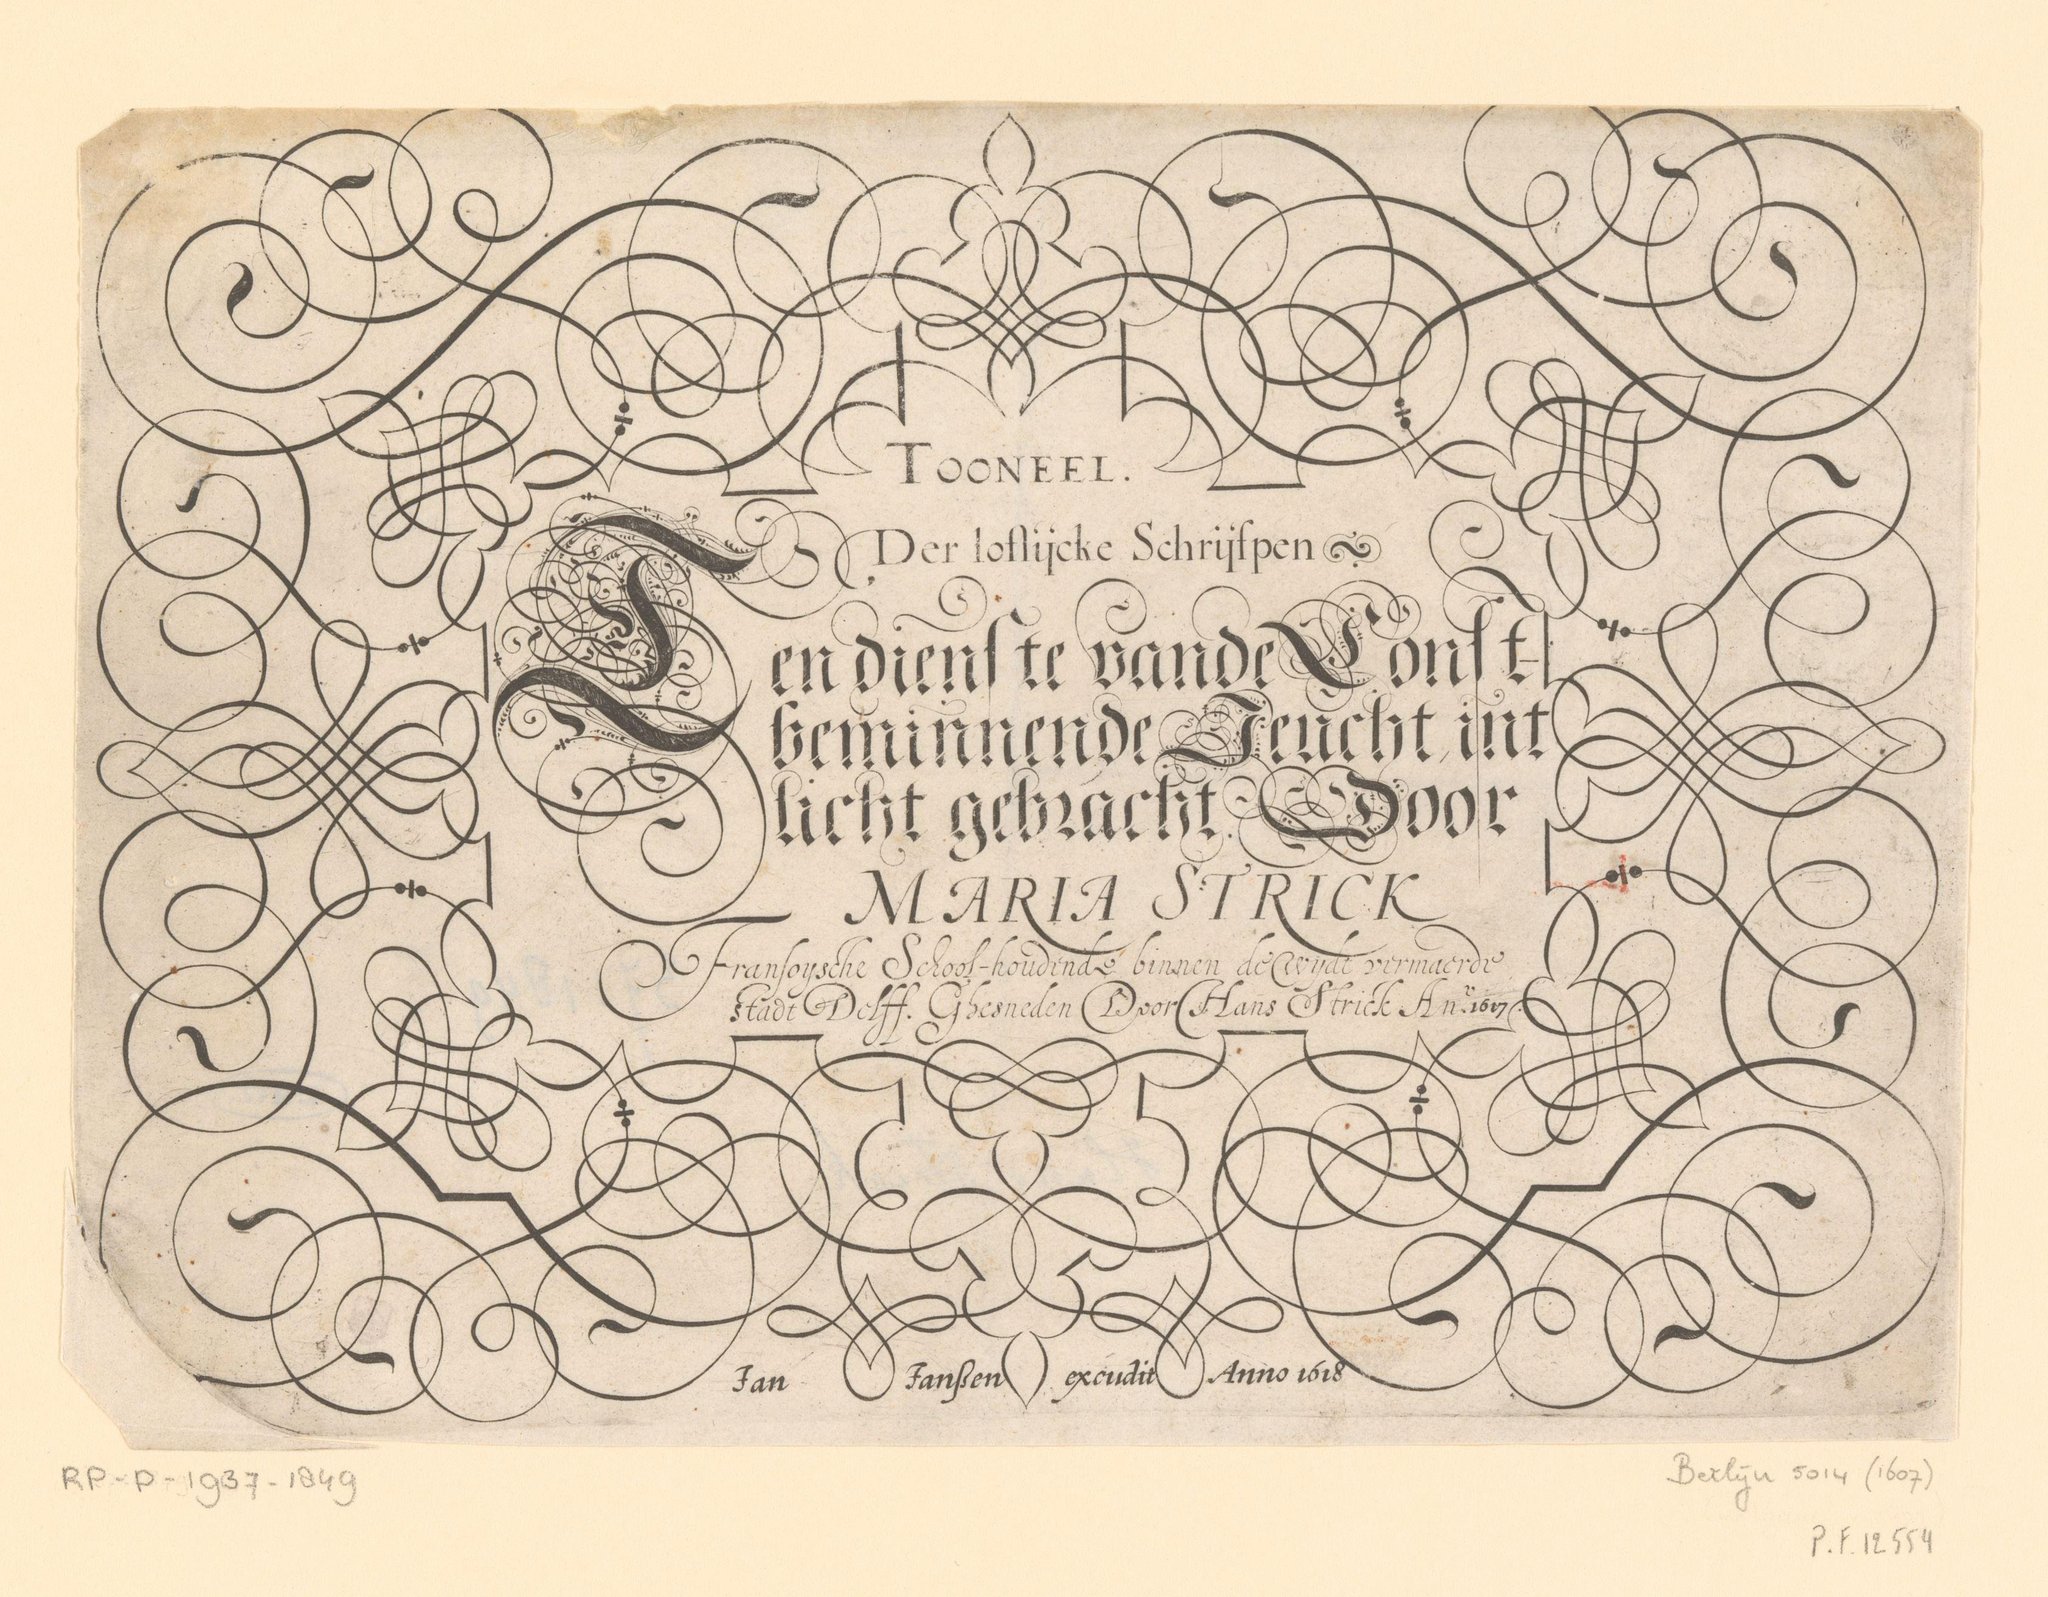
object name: titelprent, frontispice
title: Tooneel Der loflijcke Schrijfpen (...)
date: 1617-1618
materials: paper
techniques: engraving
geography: amsterdam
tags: calligraphy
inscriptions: collector's mark: Lugt 2228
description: Gekalligrafeerde tekst: Tooneel Der loflijcke Schrijfpen (...). Rondom een omlijsting van vlechtwerk.